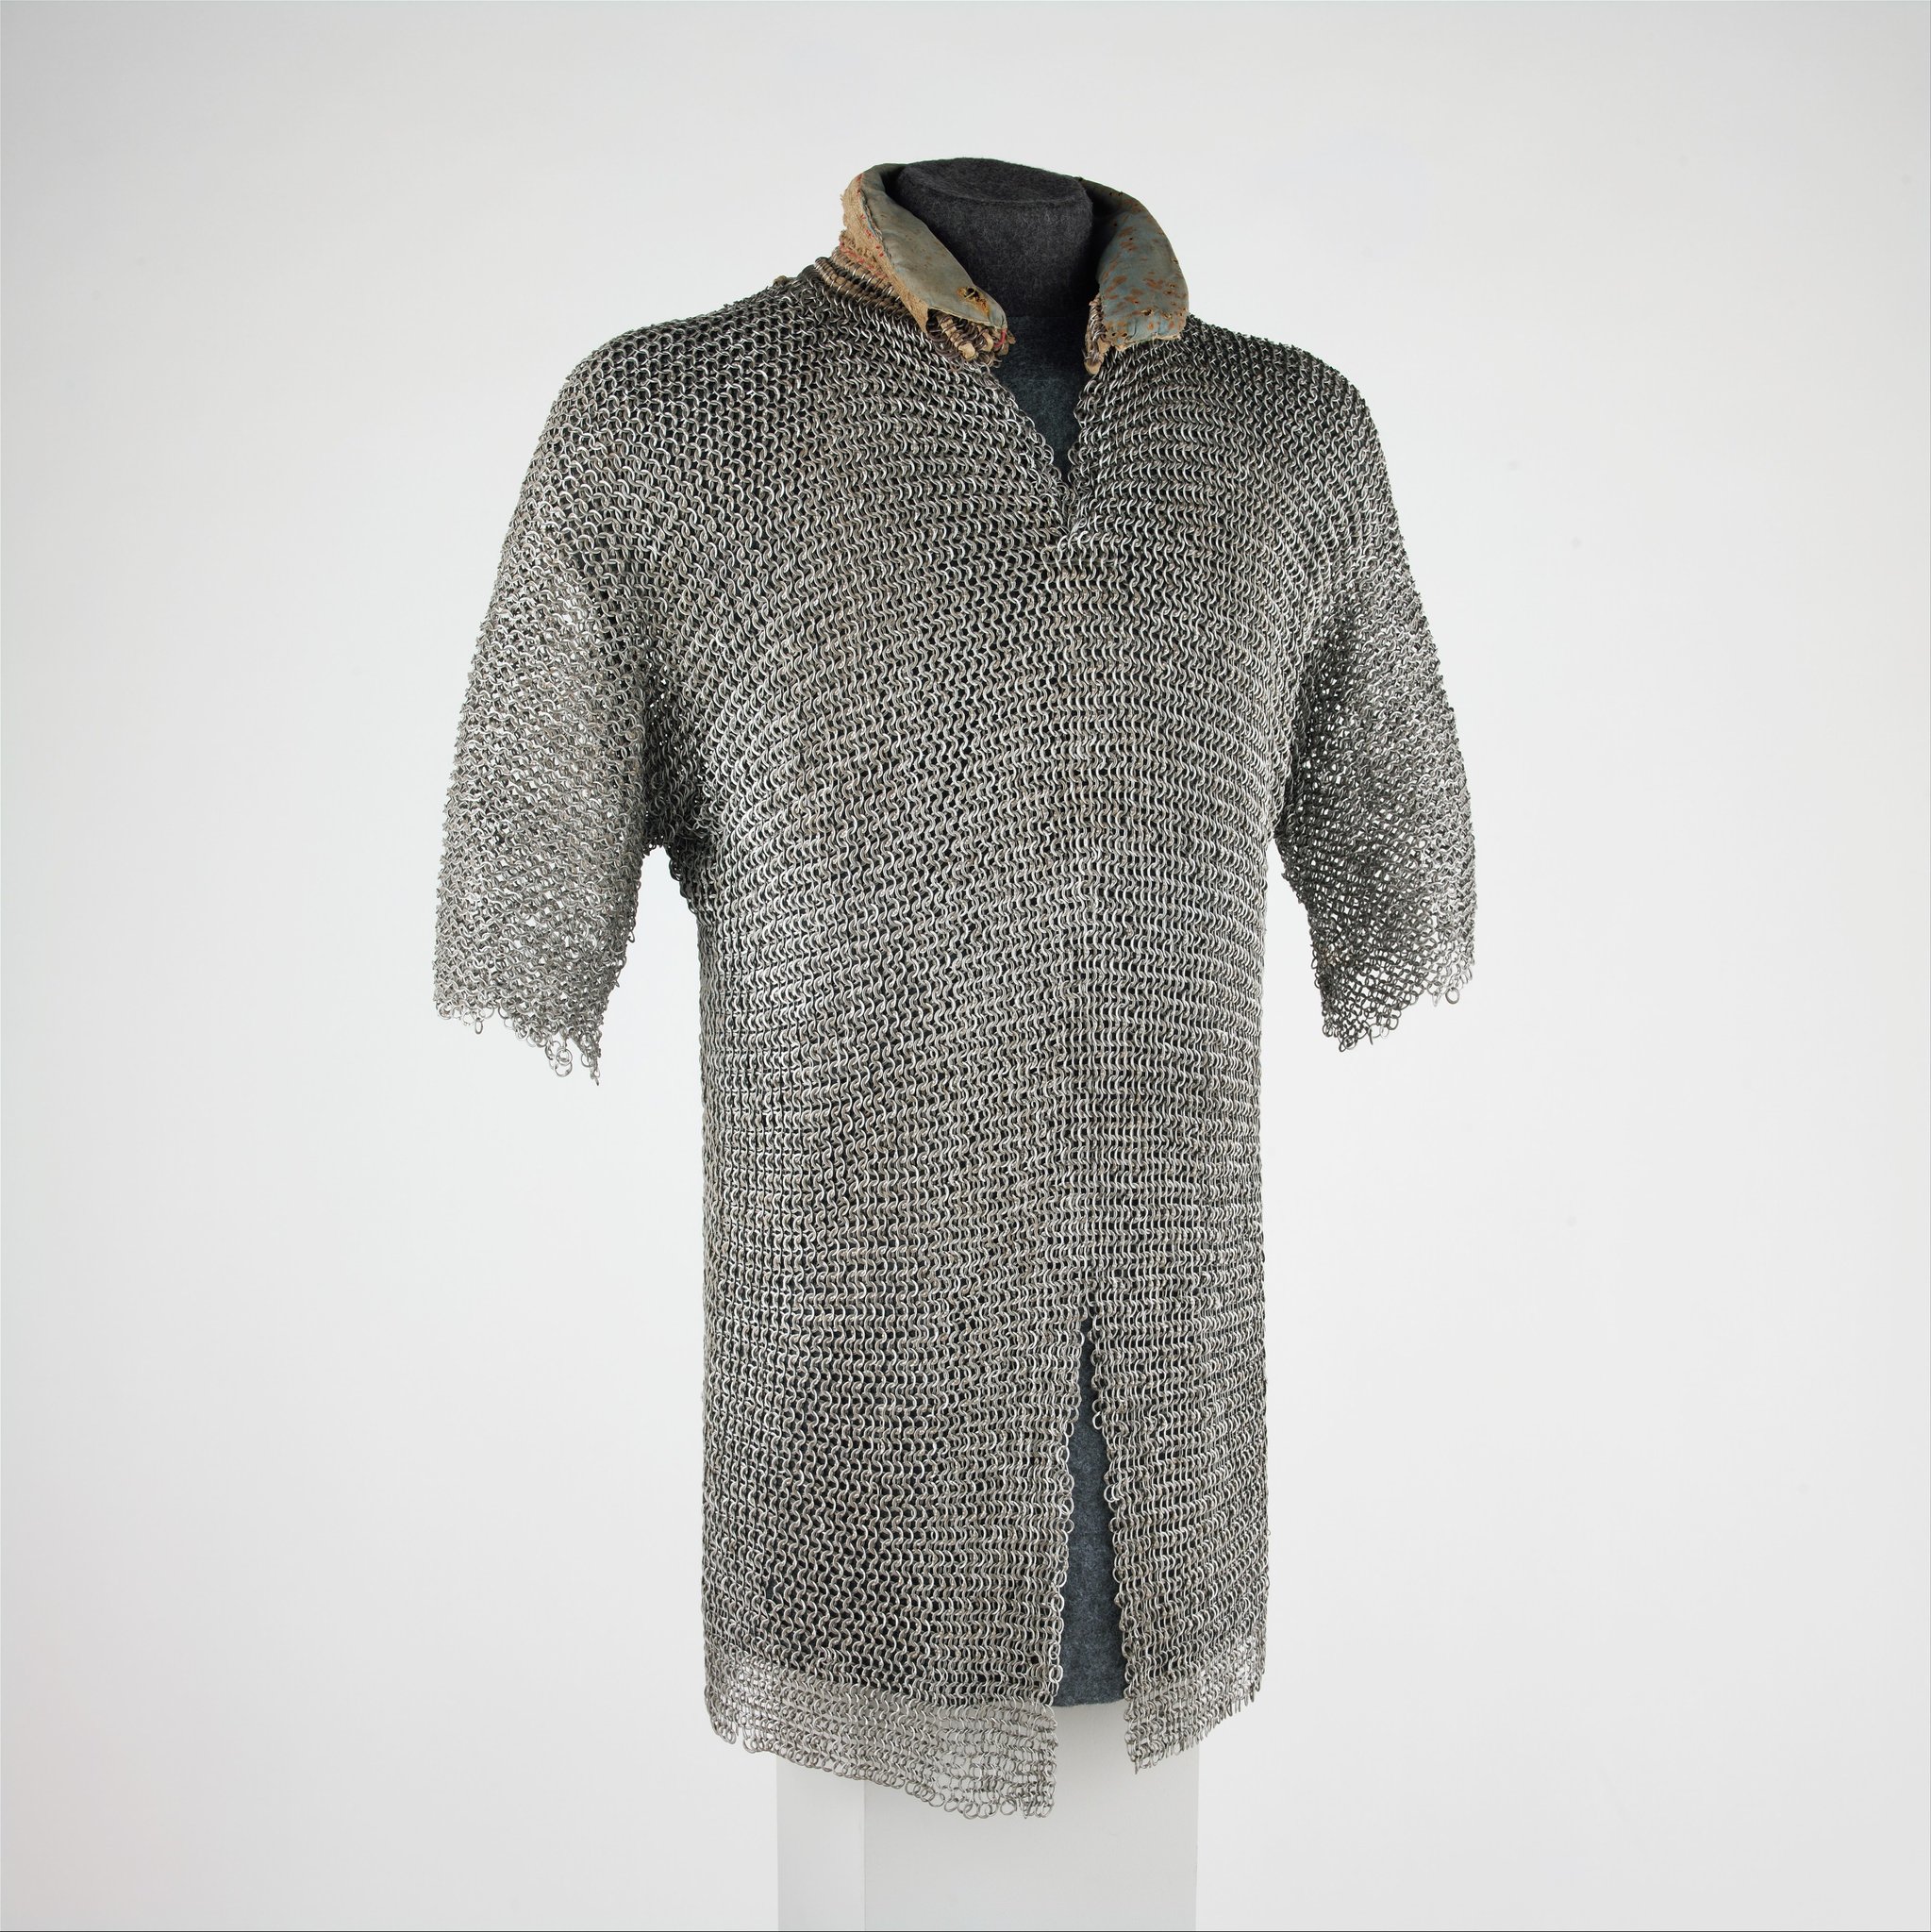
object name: mail shirt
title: Shirt of Mail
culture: bhutanese or indian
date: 1601-1900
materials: iron, leather, textile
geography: bhutan